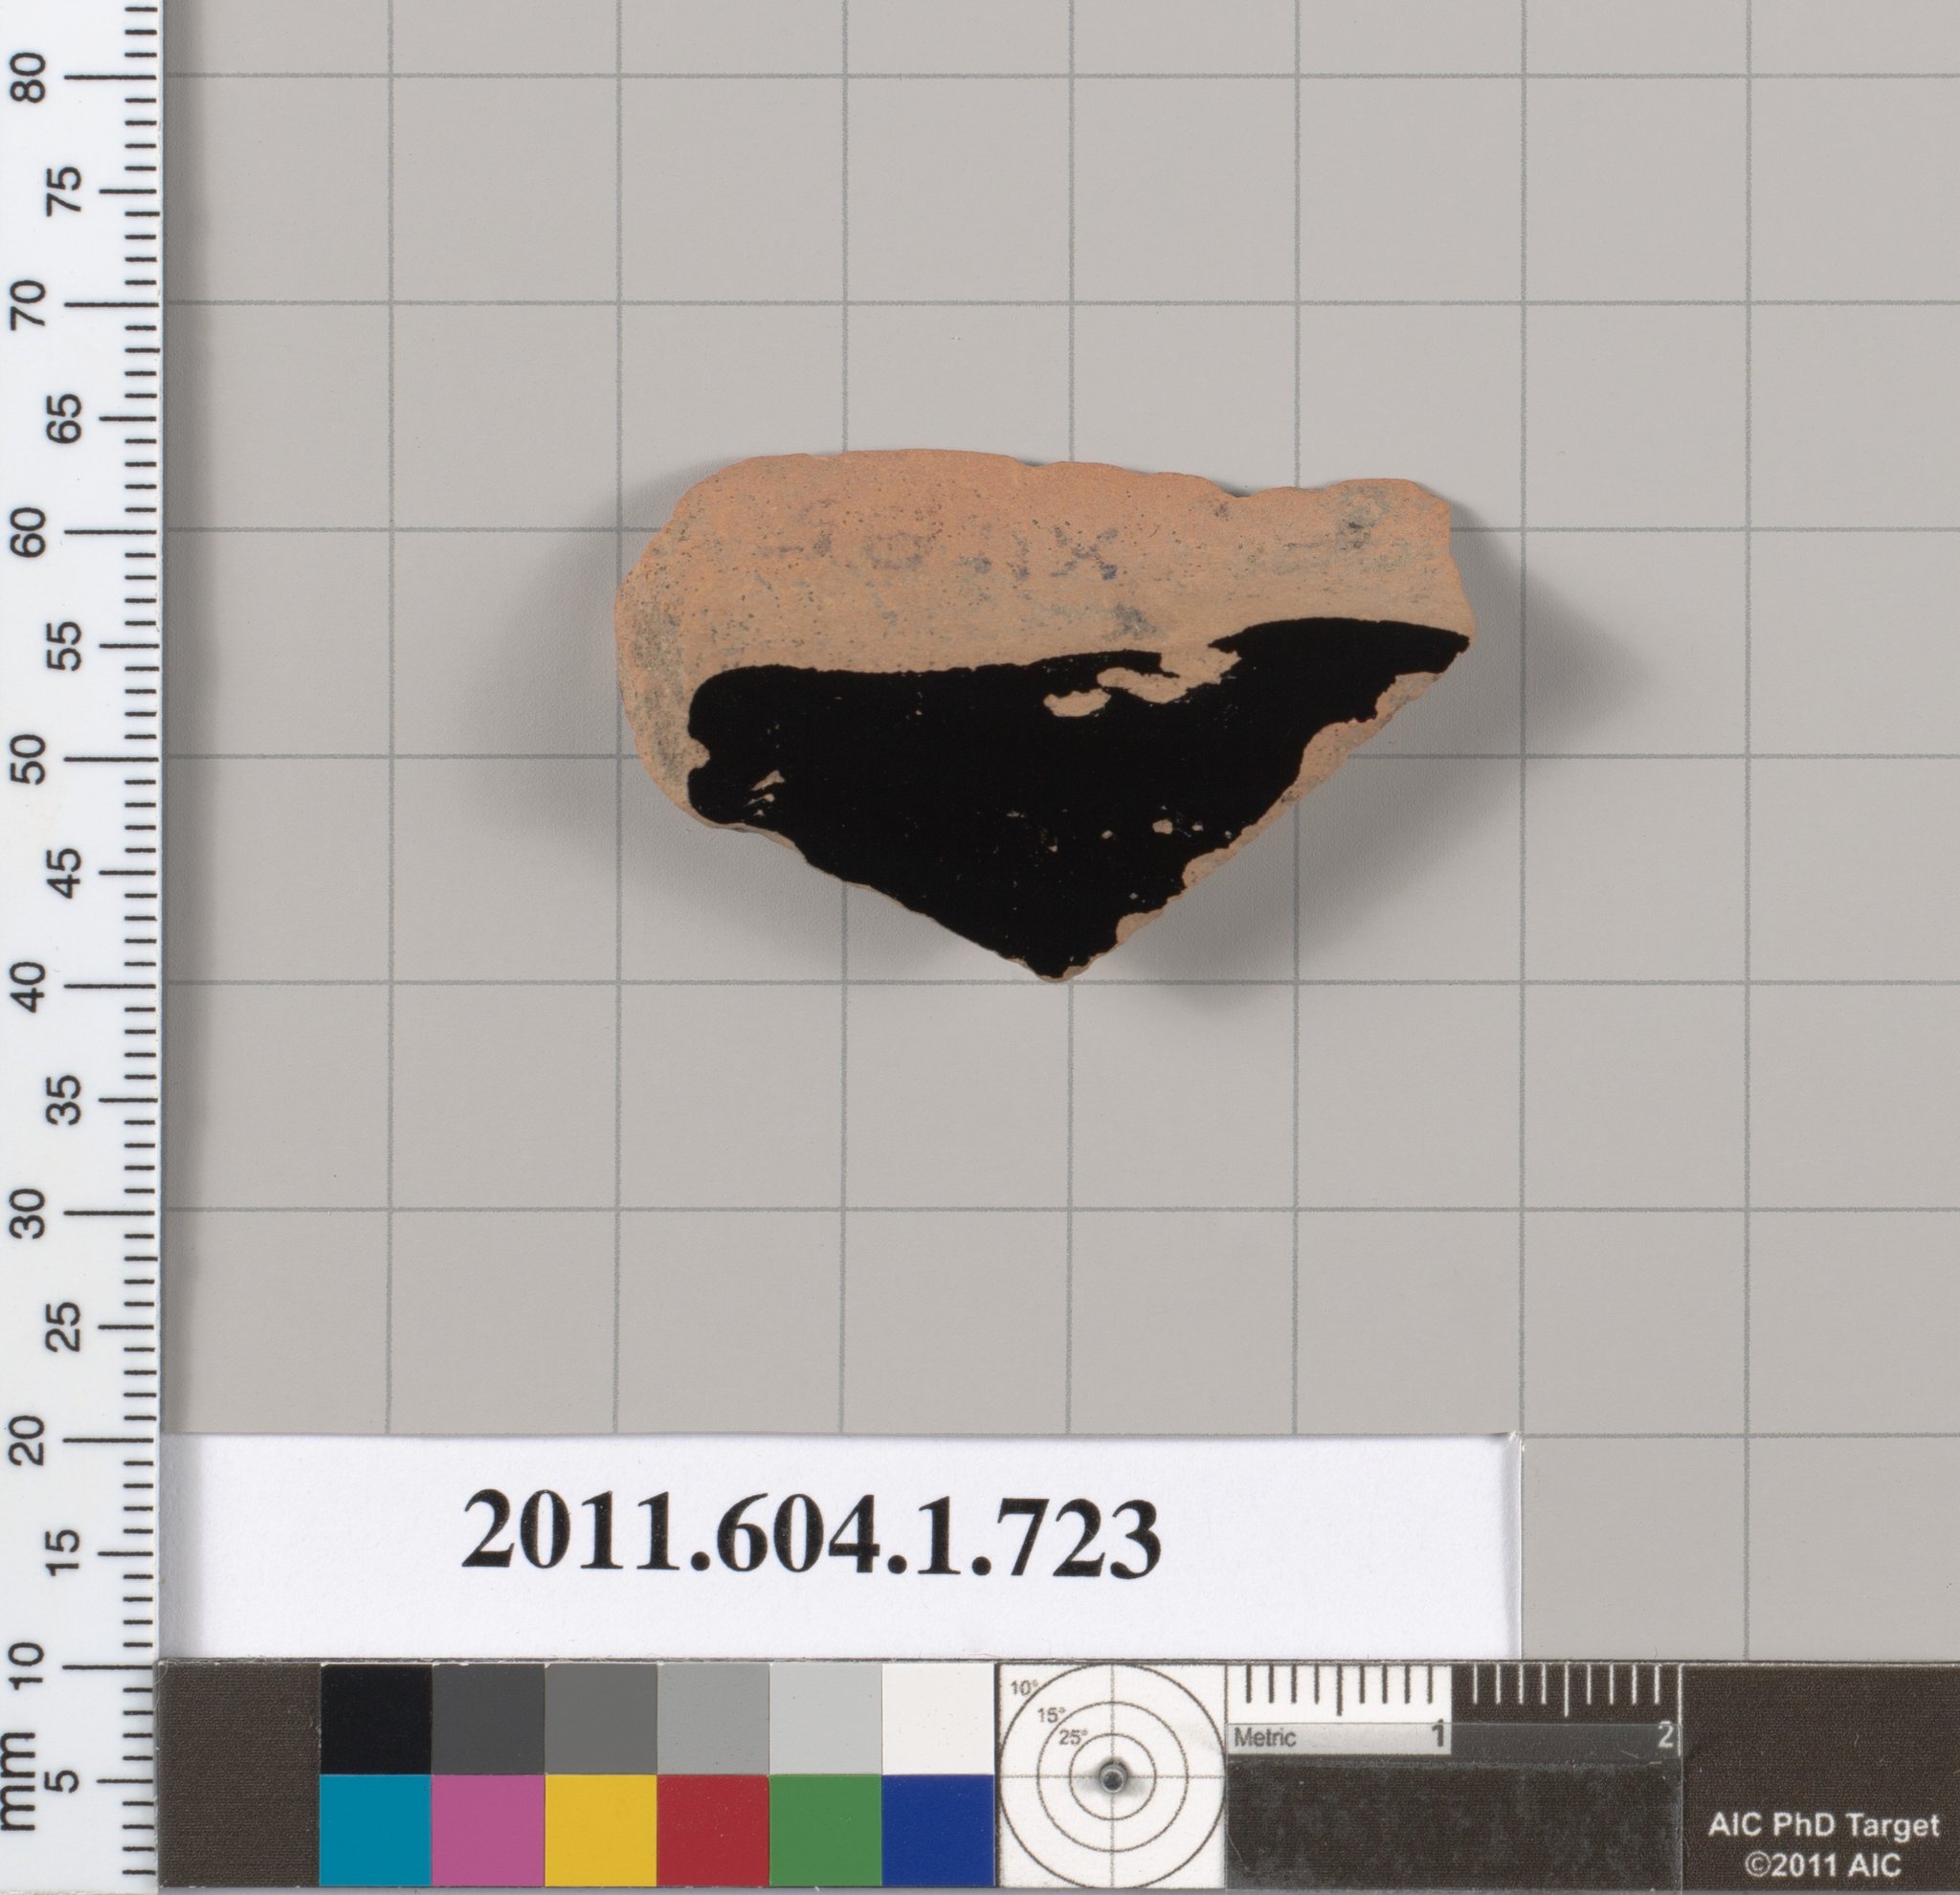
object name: kylix fragment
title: Terracotta fragment of a kylix (drinking cup)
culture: greek, attic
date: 475-451 BCE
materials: terracotta